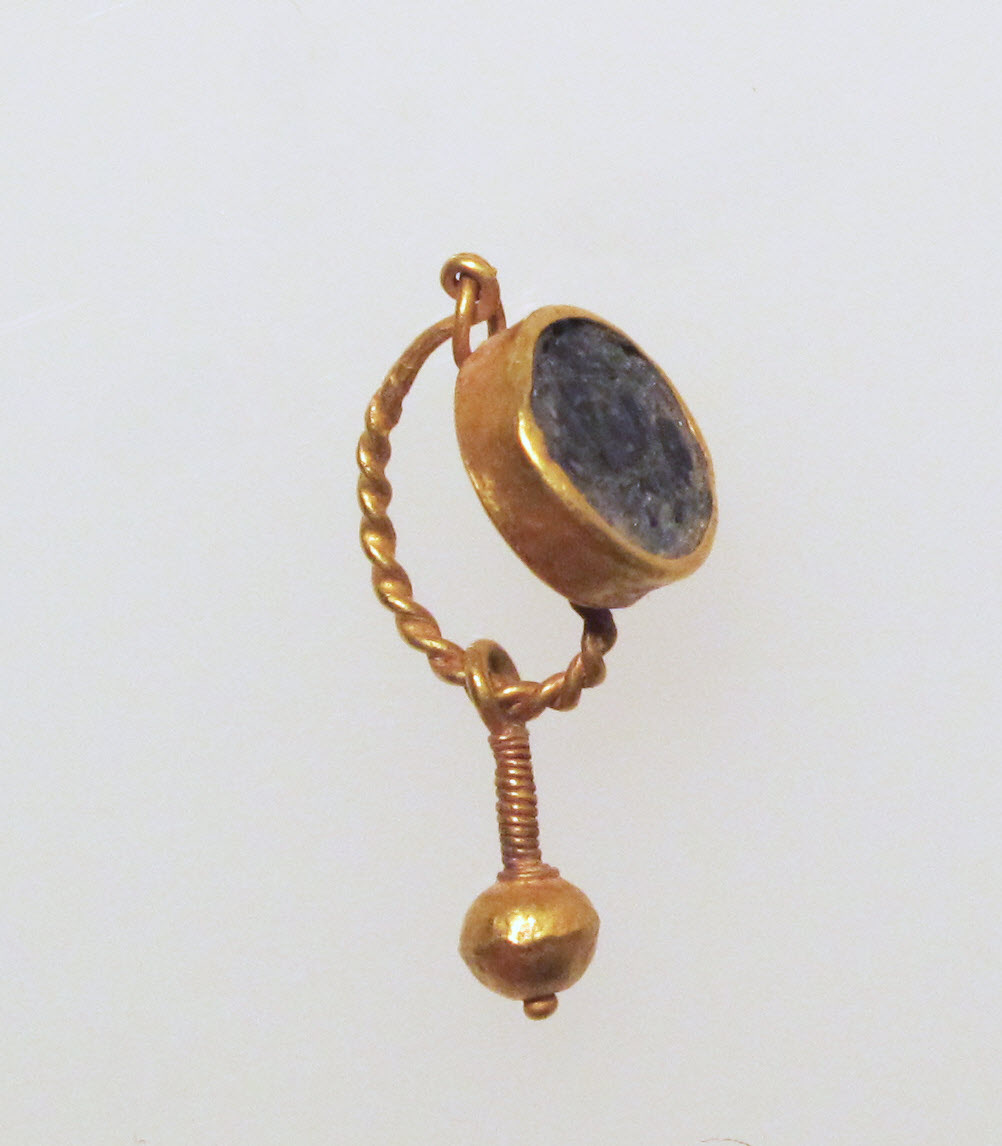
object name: earring hook type with ball pendant and paste setting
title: Earring with ball pendant and paste setting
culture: roman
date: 1-200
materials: glass, gold, paste